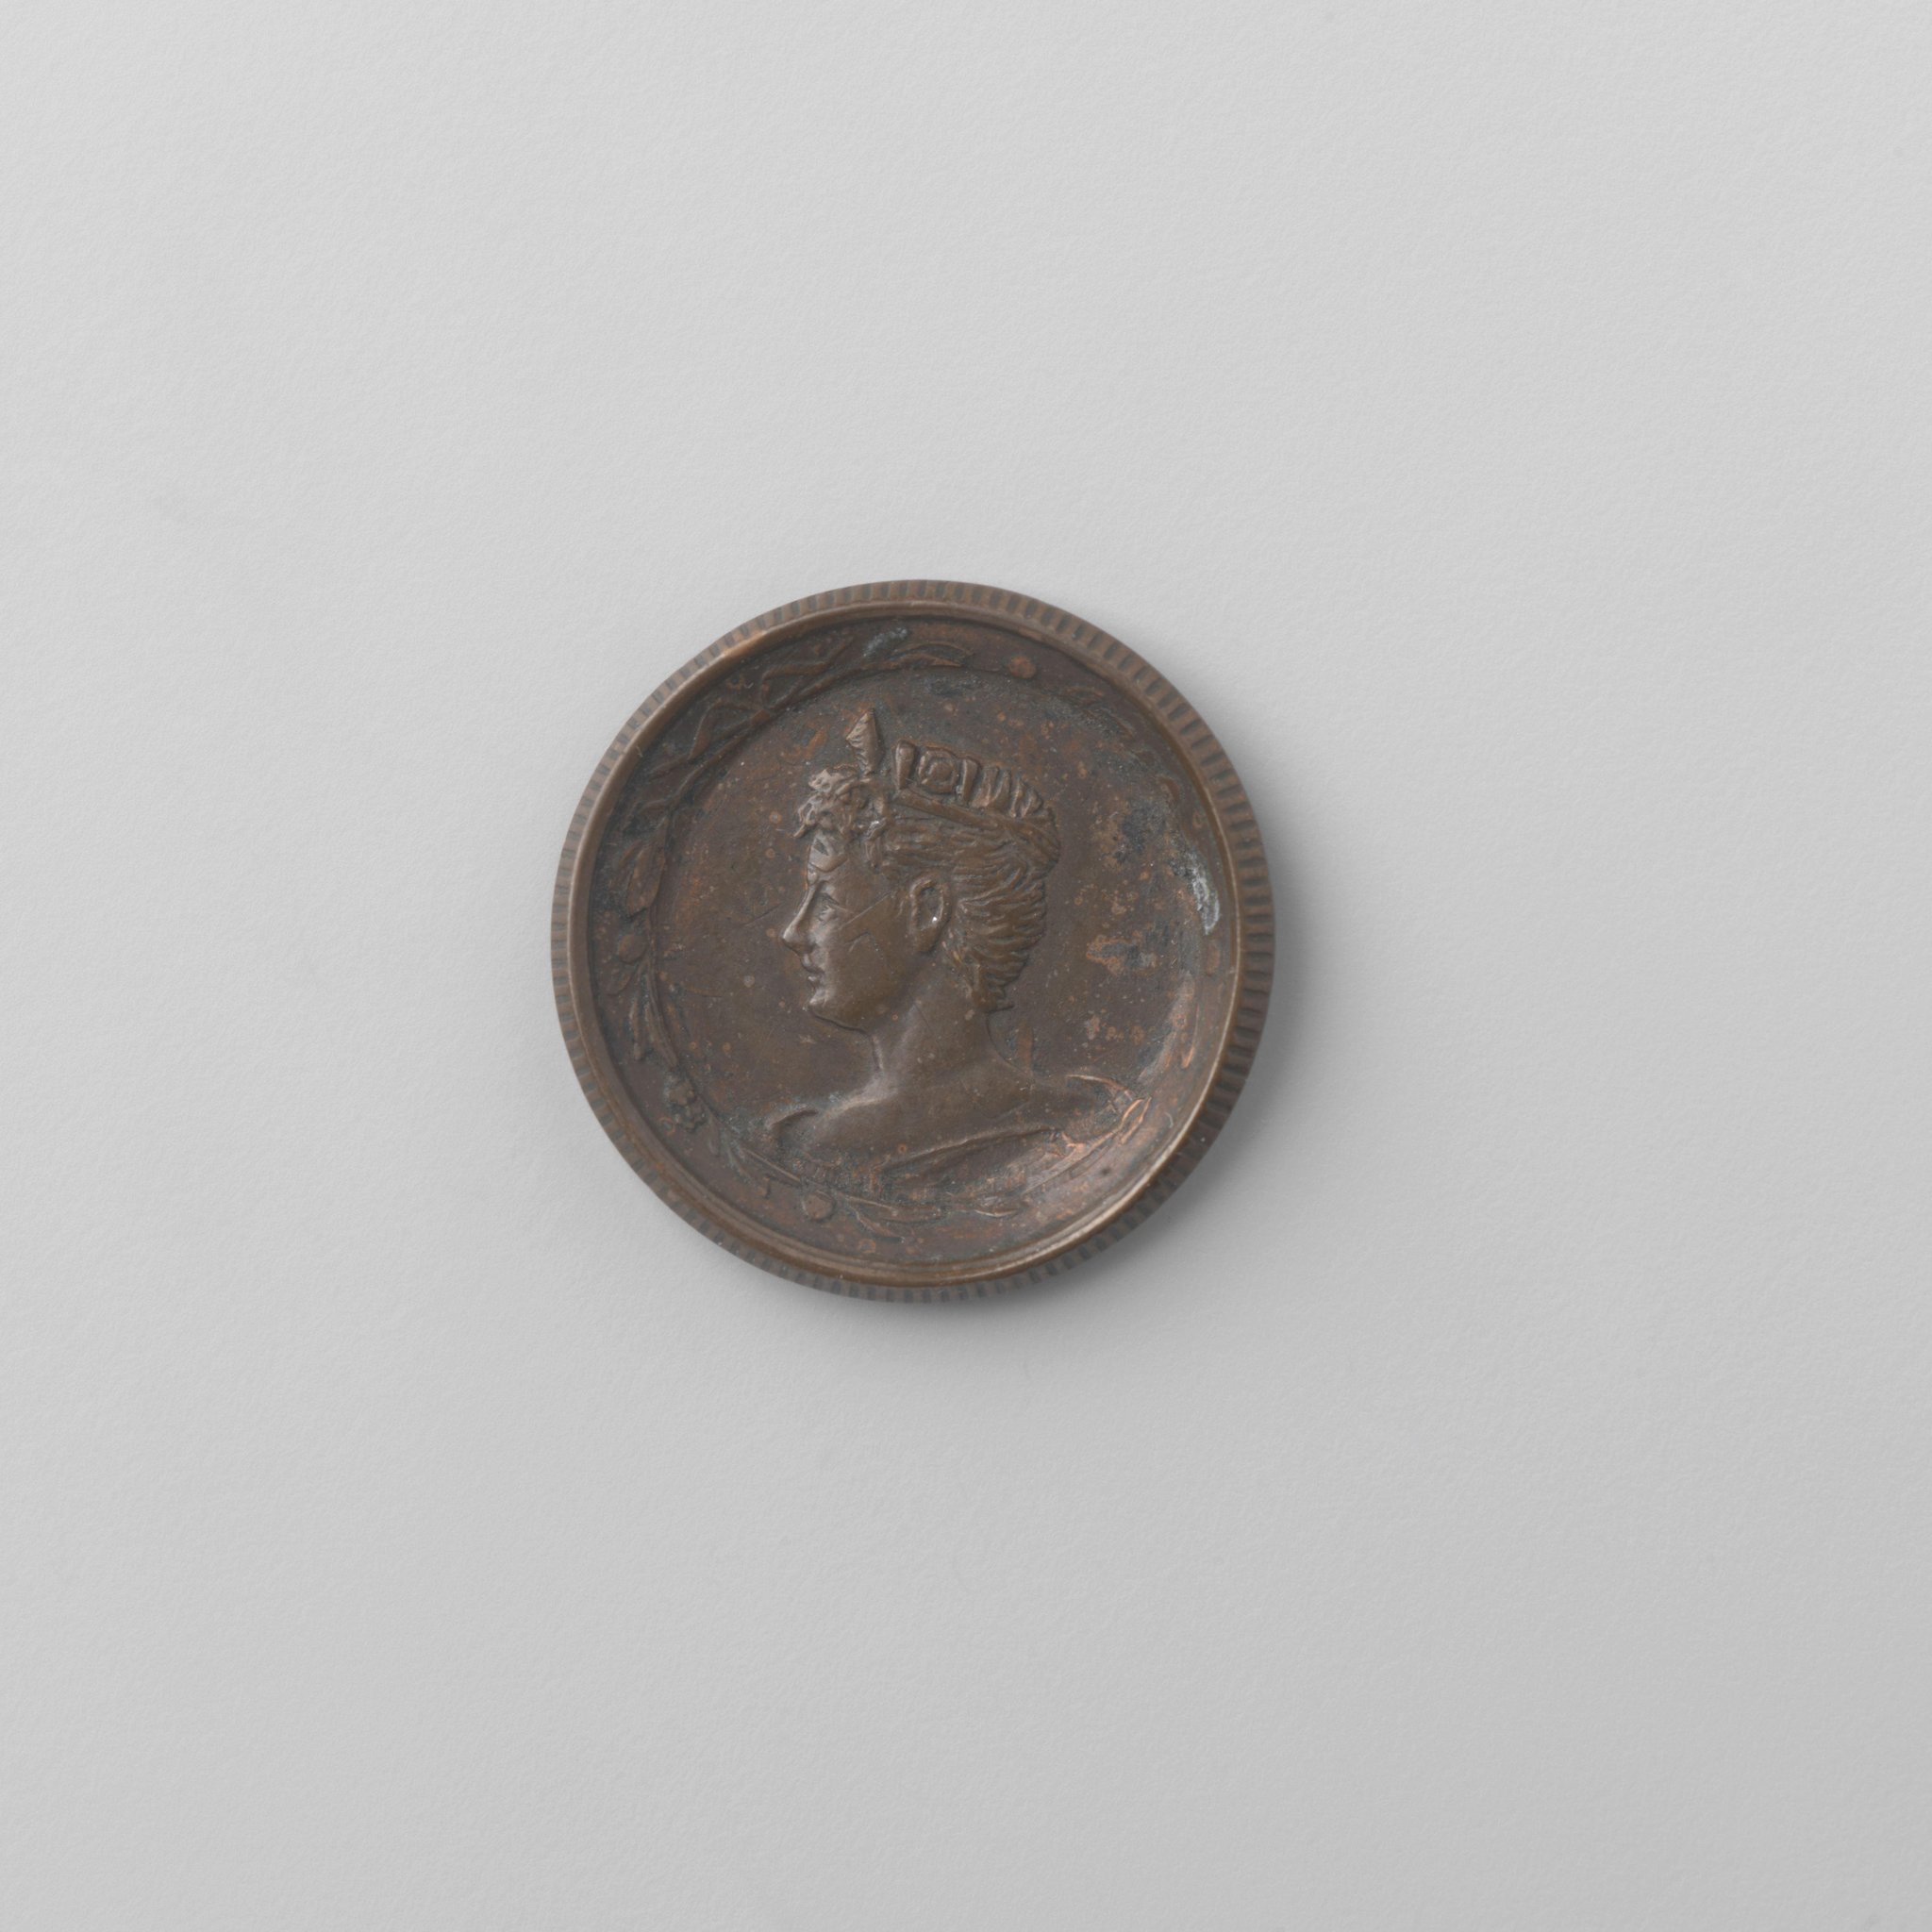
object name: coin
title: Nederland, cent,1898 met gedrapeerd borstbeeld van Wilhelmina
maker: wilhelmina of the netherlands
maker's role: print maker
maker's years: 1880-1962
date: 1898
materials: bronze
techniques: striking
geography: utrecht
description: Bronzen munt. Op munt van een cent ingeslagen op voorzijde: gedrapeerd portret van koningin Wilhelmina. Keerrzijde: glad veld. Jaartal onderaan in omschrift.Kartelrand.